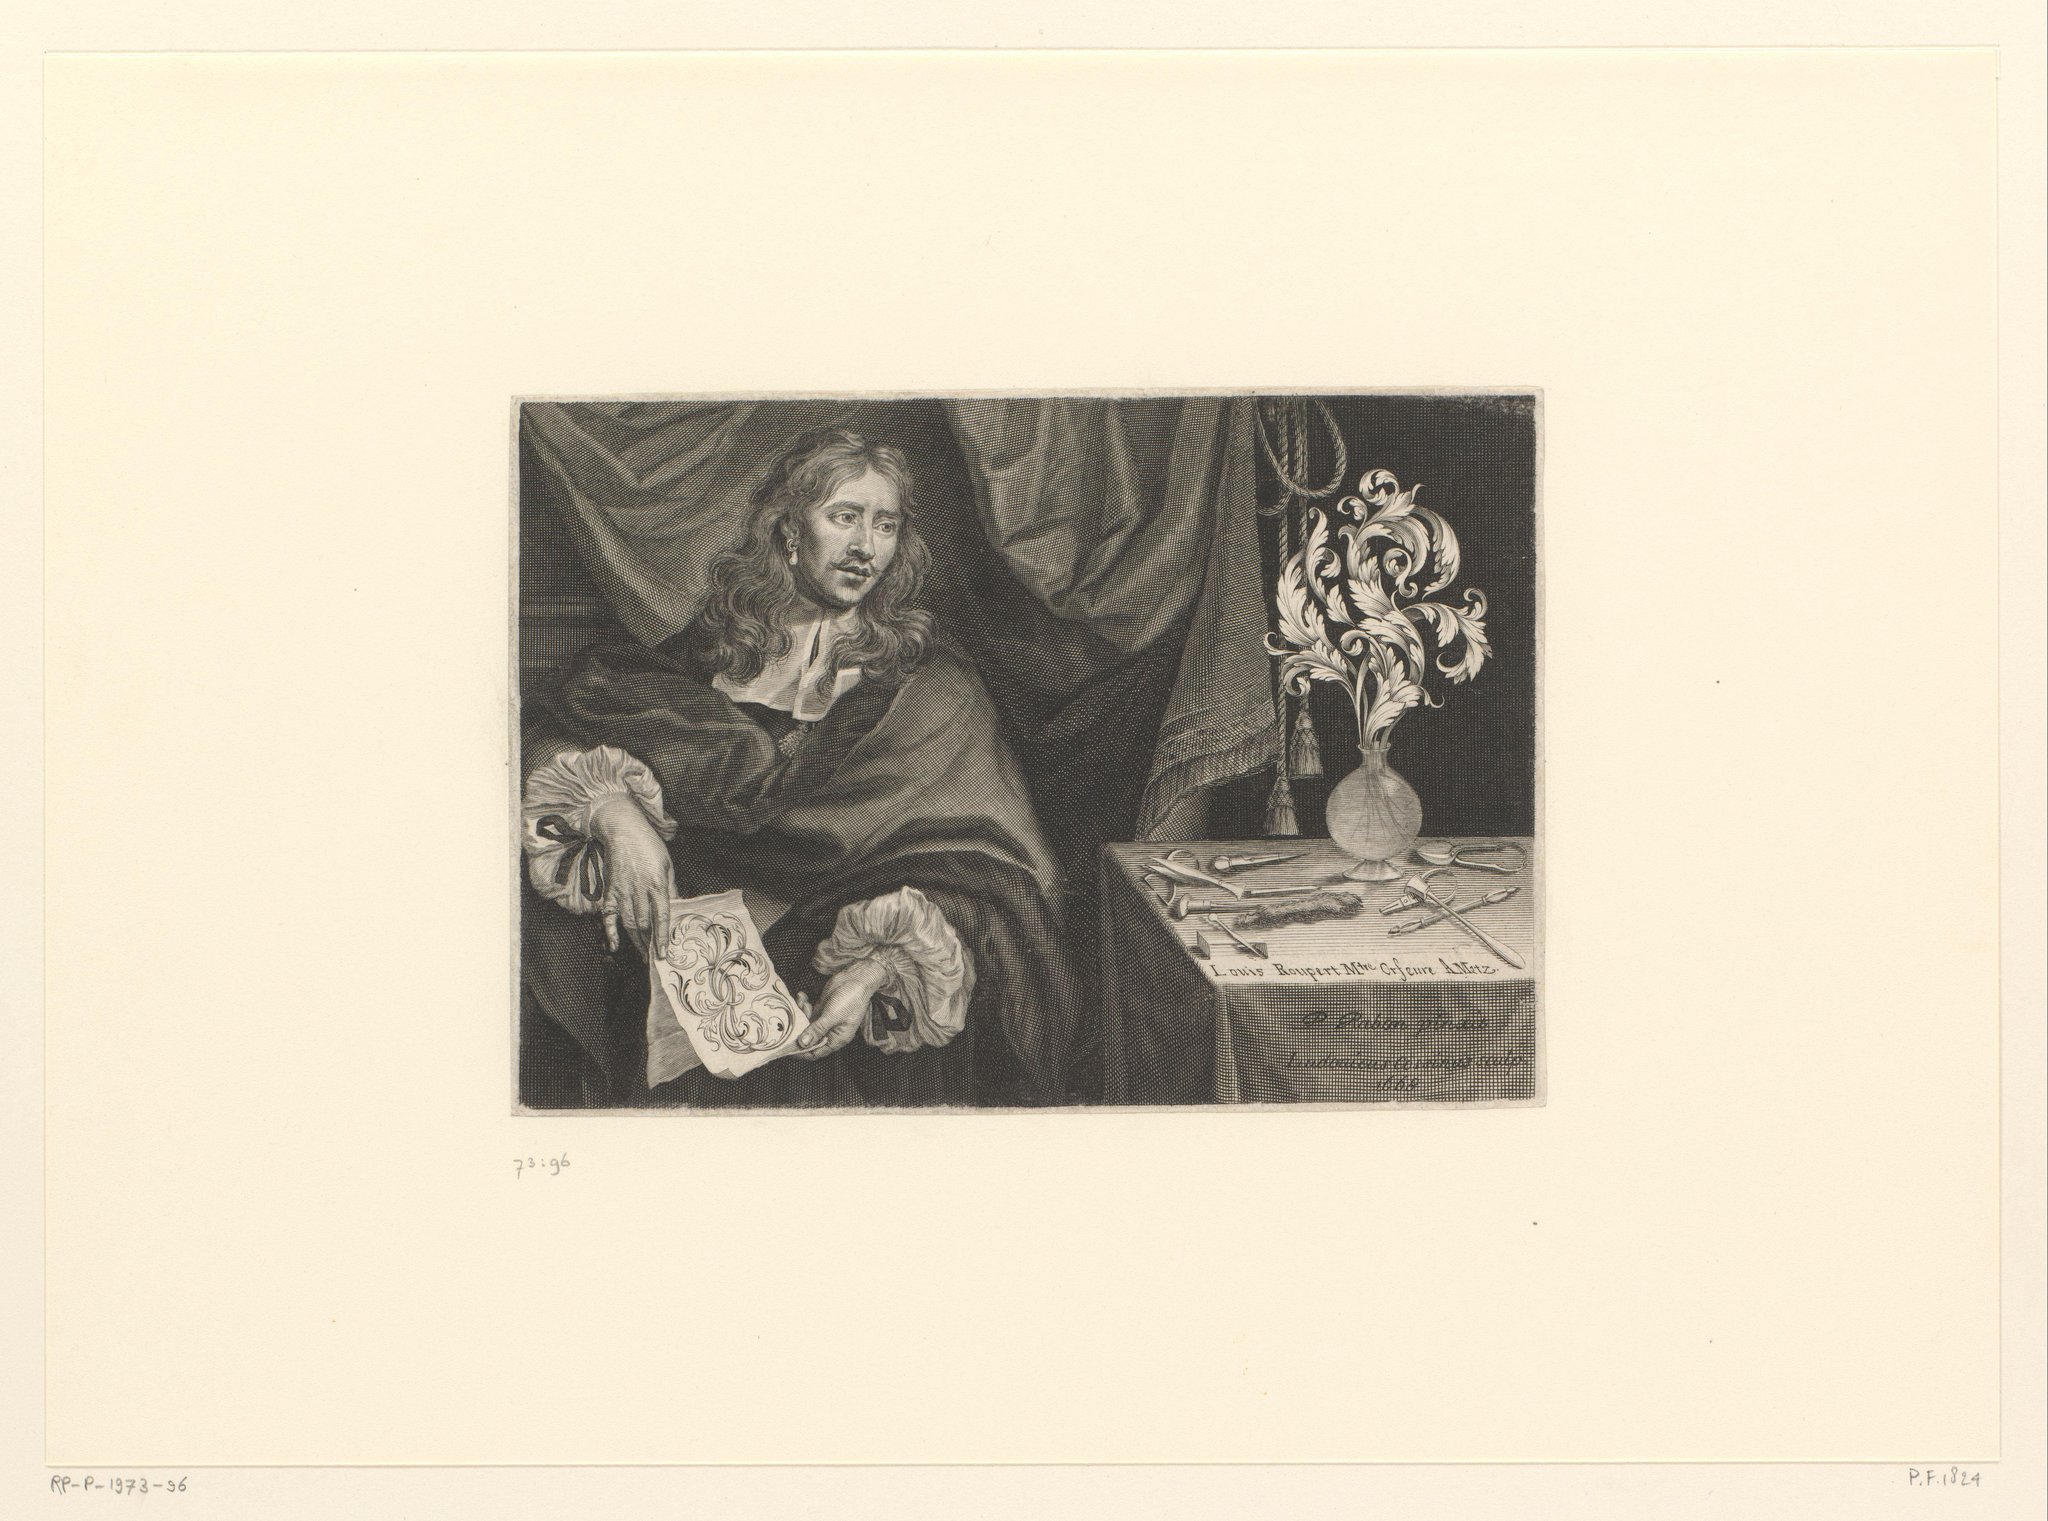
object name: titelprent, frontispice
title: Titelprent met het portret van Louis Roupert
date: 1668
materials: paper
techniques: engraving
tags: paris, print maker, goldsmith, louis roupert, tools, implements of craftsman (with name), ear-rings (+ men's clothes), historical persons, jeweller, goldsmith, silversmith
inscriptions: signature: ‘Ludovicus Cossius sculp.’, collector's mark: Lugt 2228, collector's mark: Lugt 2760, signature: ‘P. Rabon pinxit’, inscription: ‘P. mariette 1680’, date: ‘1668’, signature: ‘Louis Roupert Mtre Orfevre A Metz’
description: Portret van de goud- en zilversmid Louis Roupert, staand naast een tafel waarop de verschillend gereedschap van de goud- en zilversmid en een vaas met bladranken. Roupert draagt een oorbel in zijn rechteroor en houdt een ontwerptekening met bladranken in zijn handen. Achter hem een draperie.